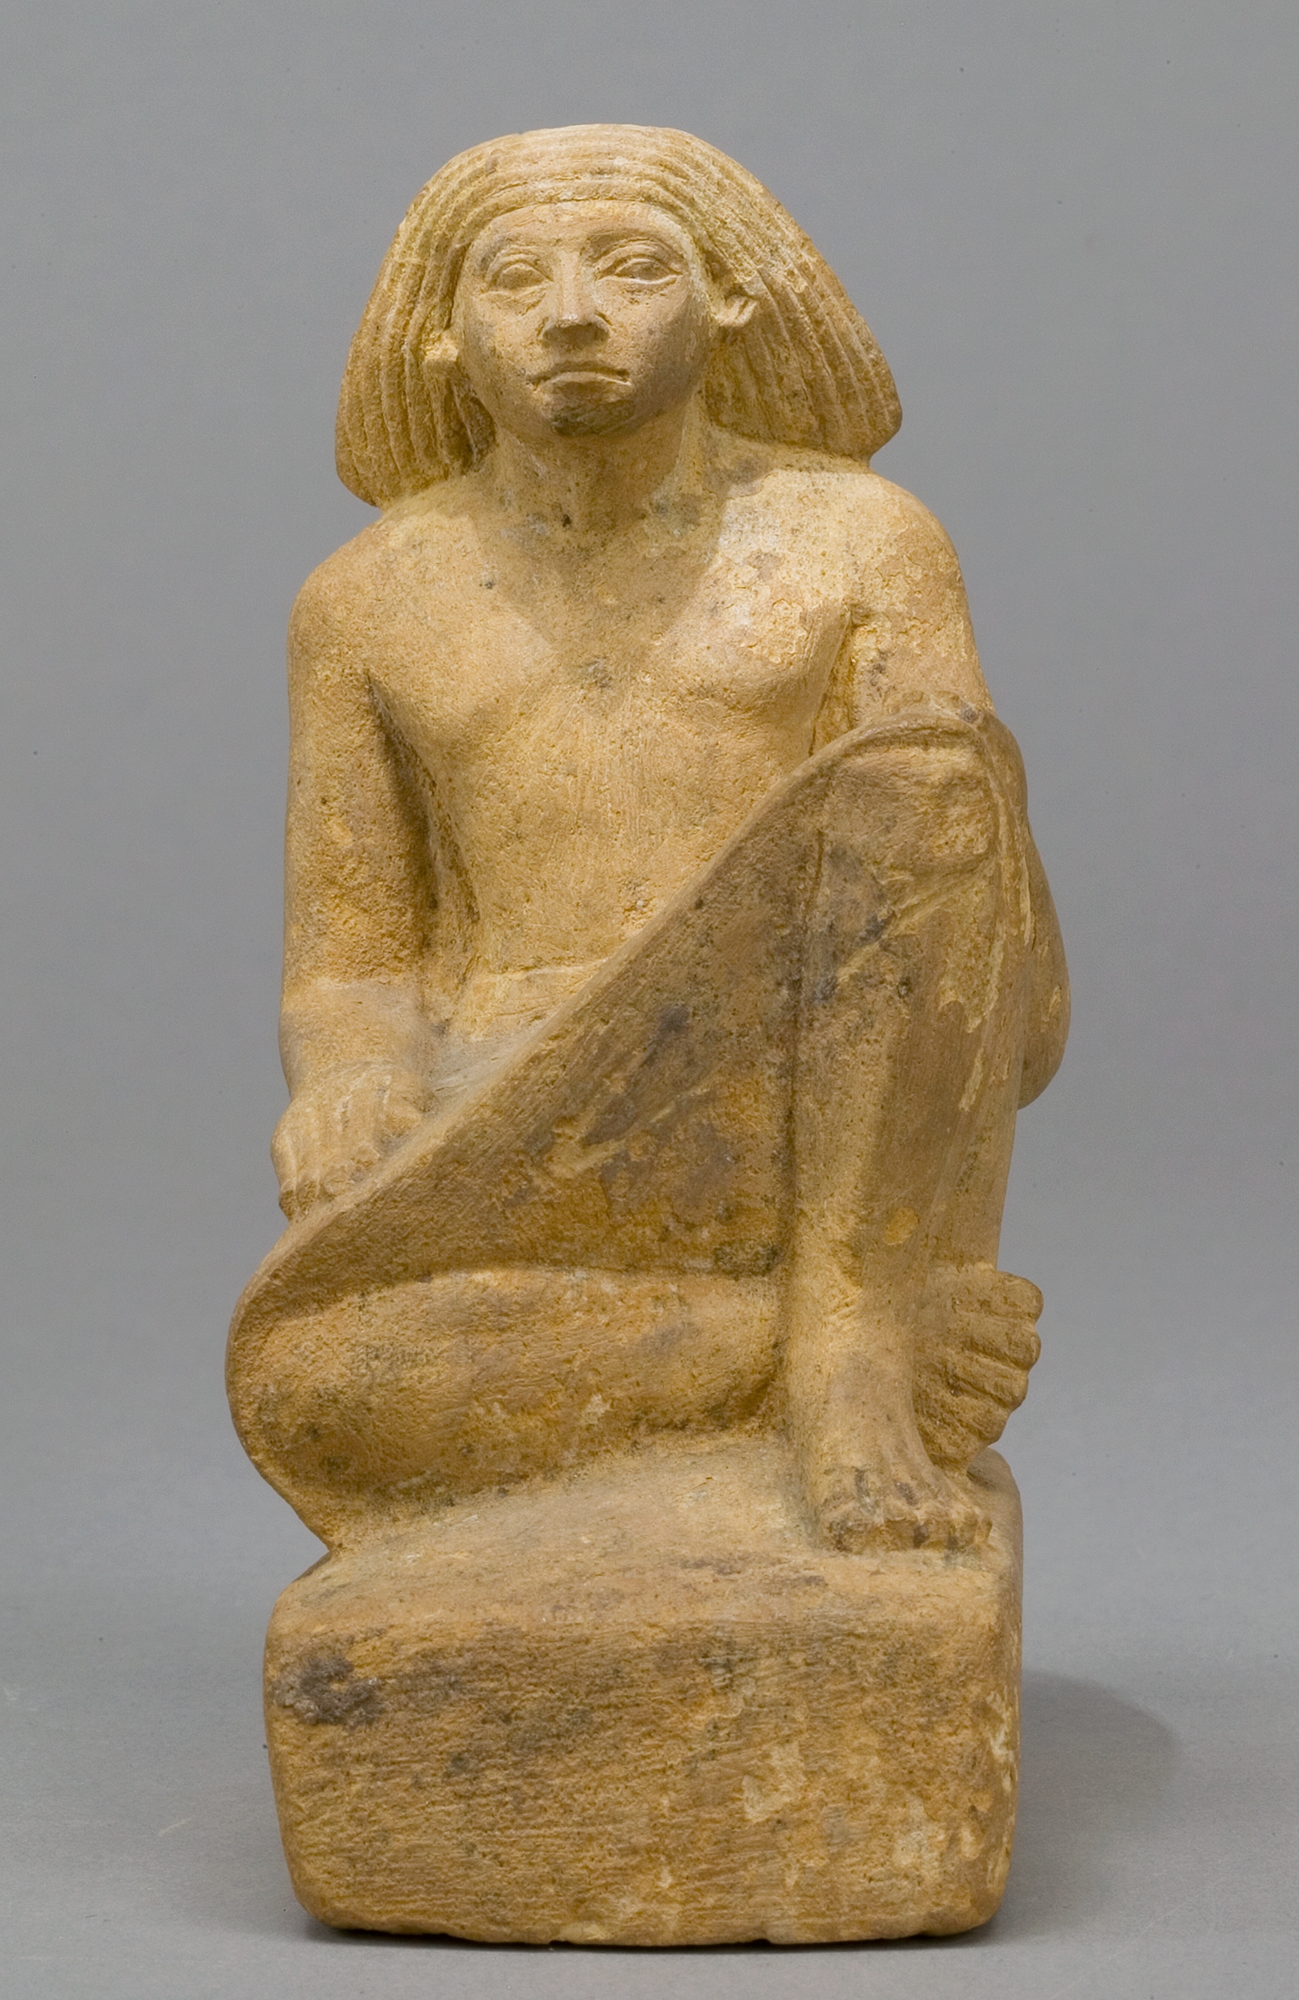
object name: statue, man seated asymmetrically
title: Statue of an asymmetrically seated man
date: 1981-1550 BCE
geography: upper egypt, thebes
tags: men